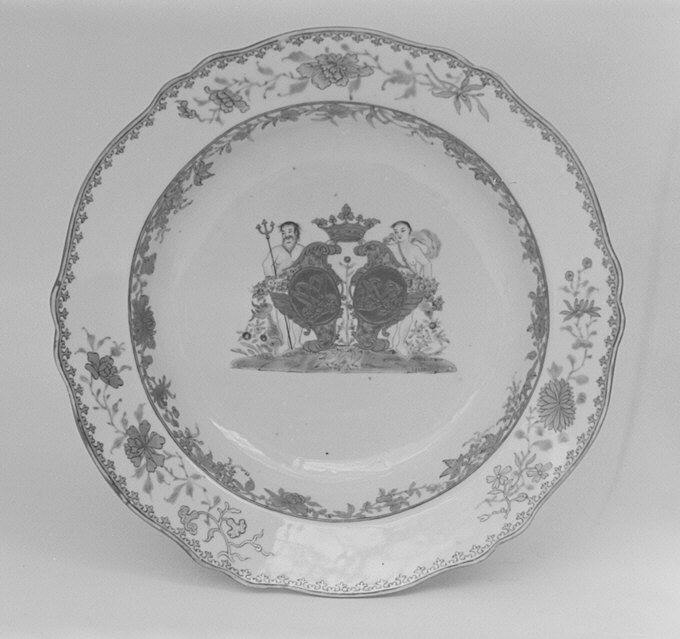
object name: soup plate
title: Soup plate (part of a service)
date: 1760-1770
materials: hard paste porcelain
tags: men,women,coat of arms